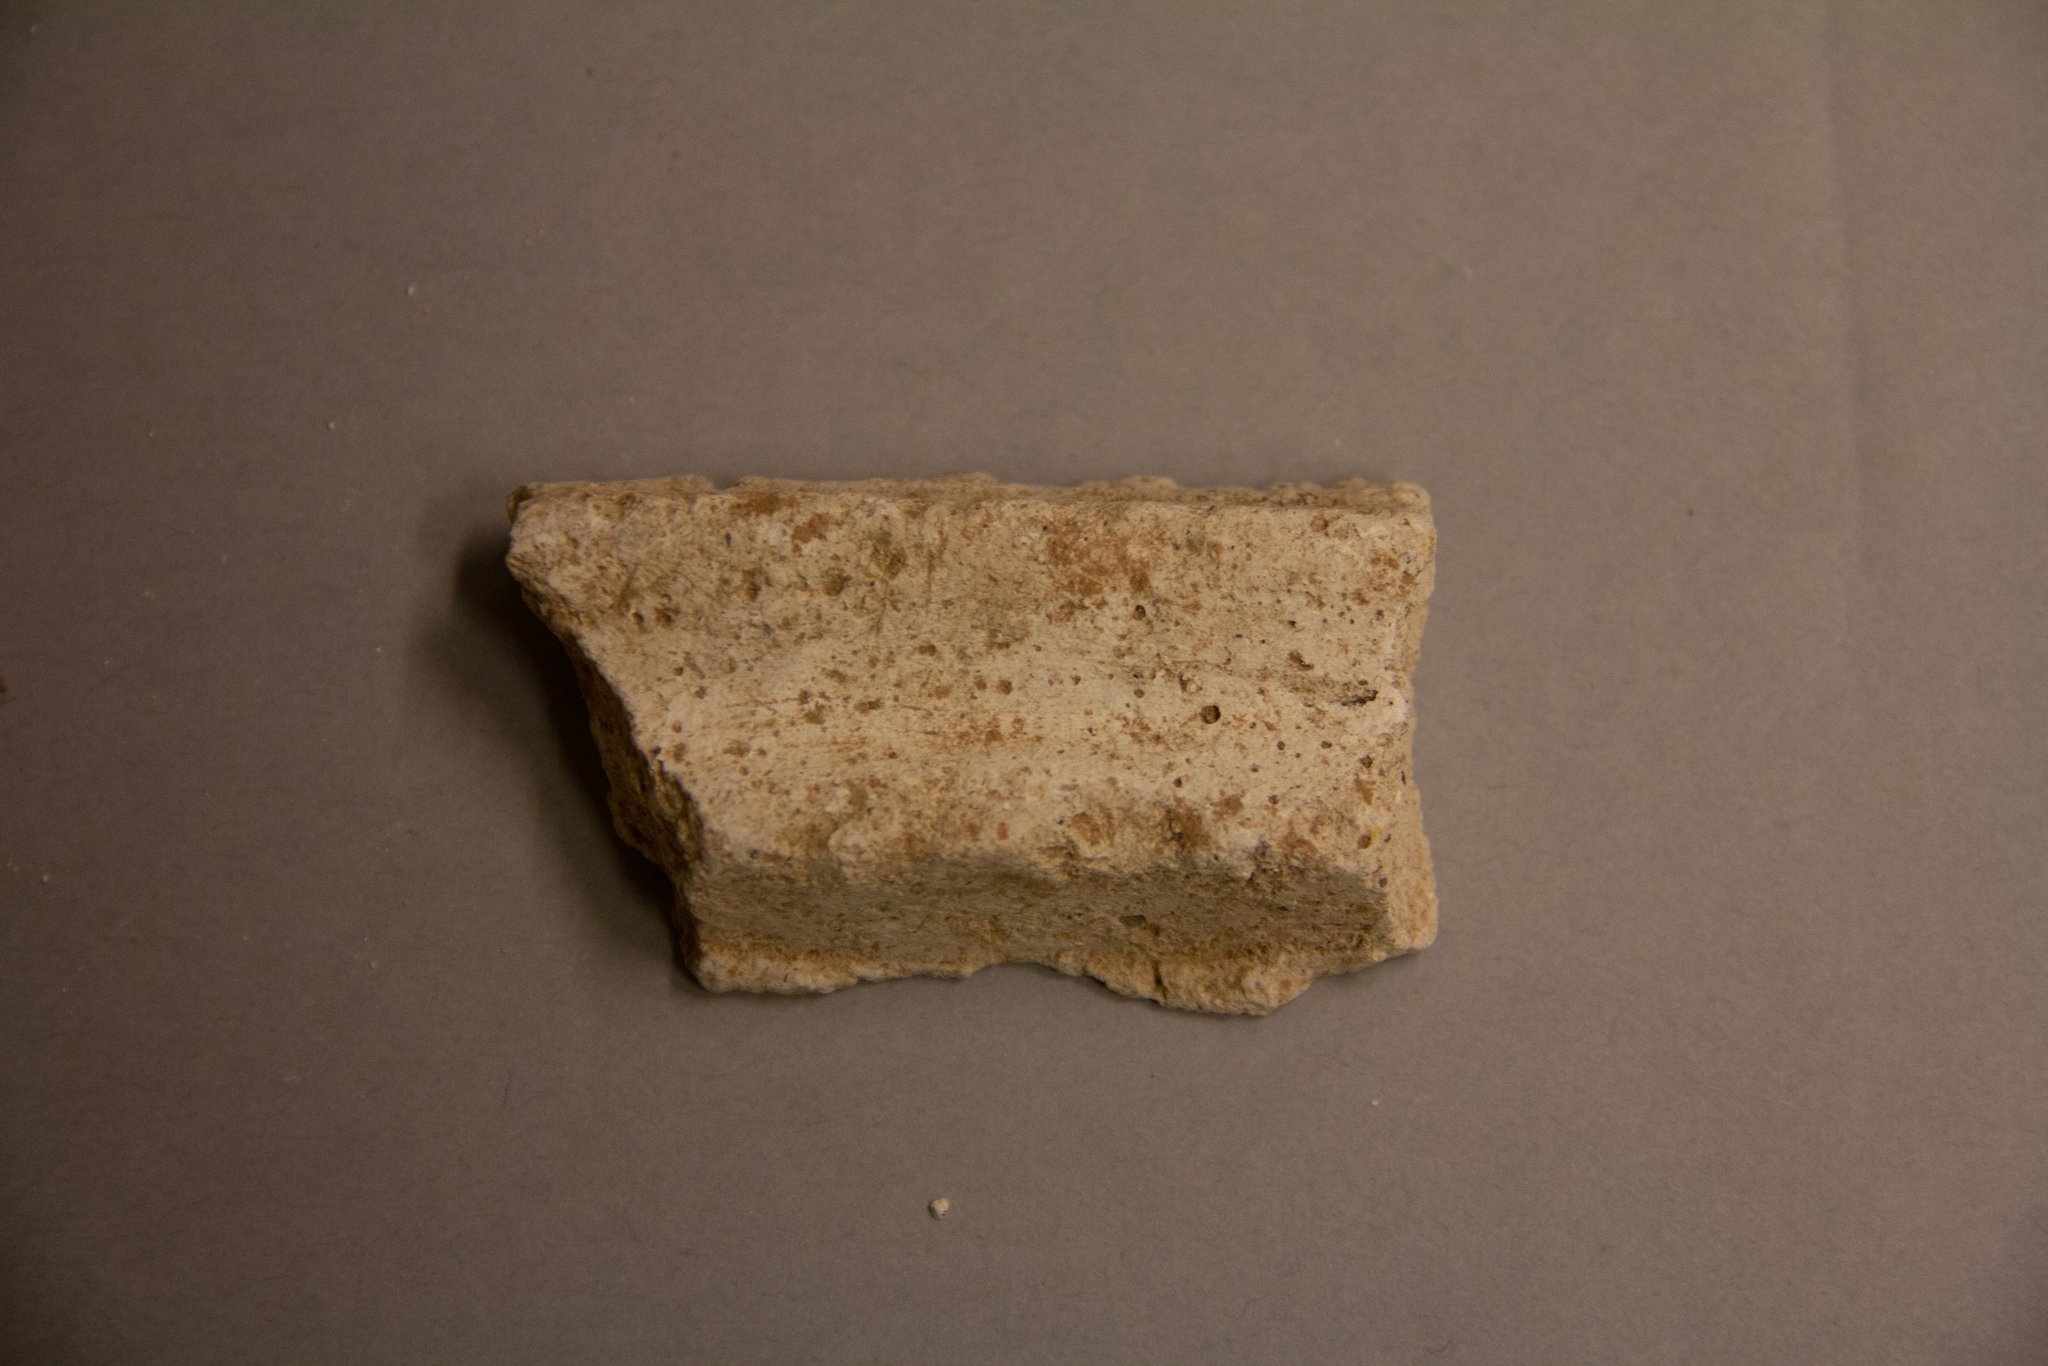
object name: fragment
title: Stucco Fragment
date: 701-1200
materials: plaster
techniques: carving, painting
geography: iran